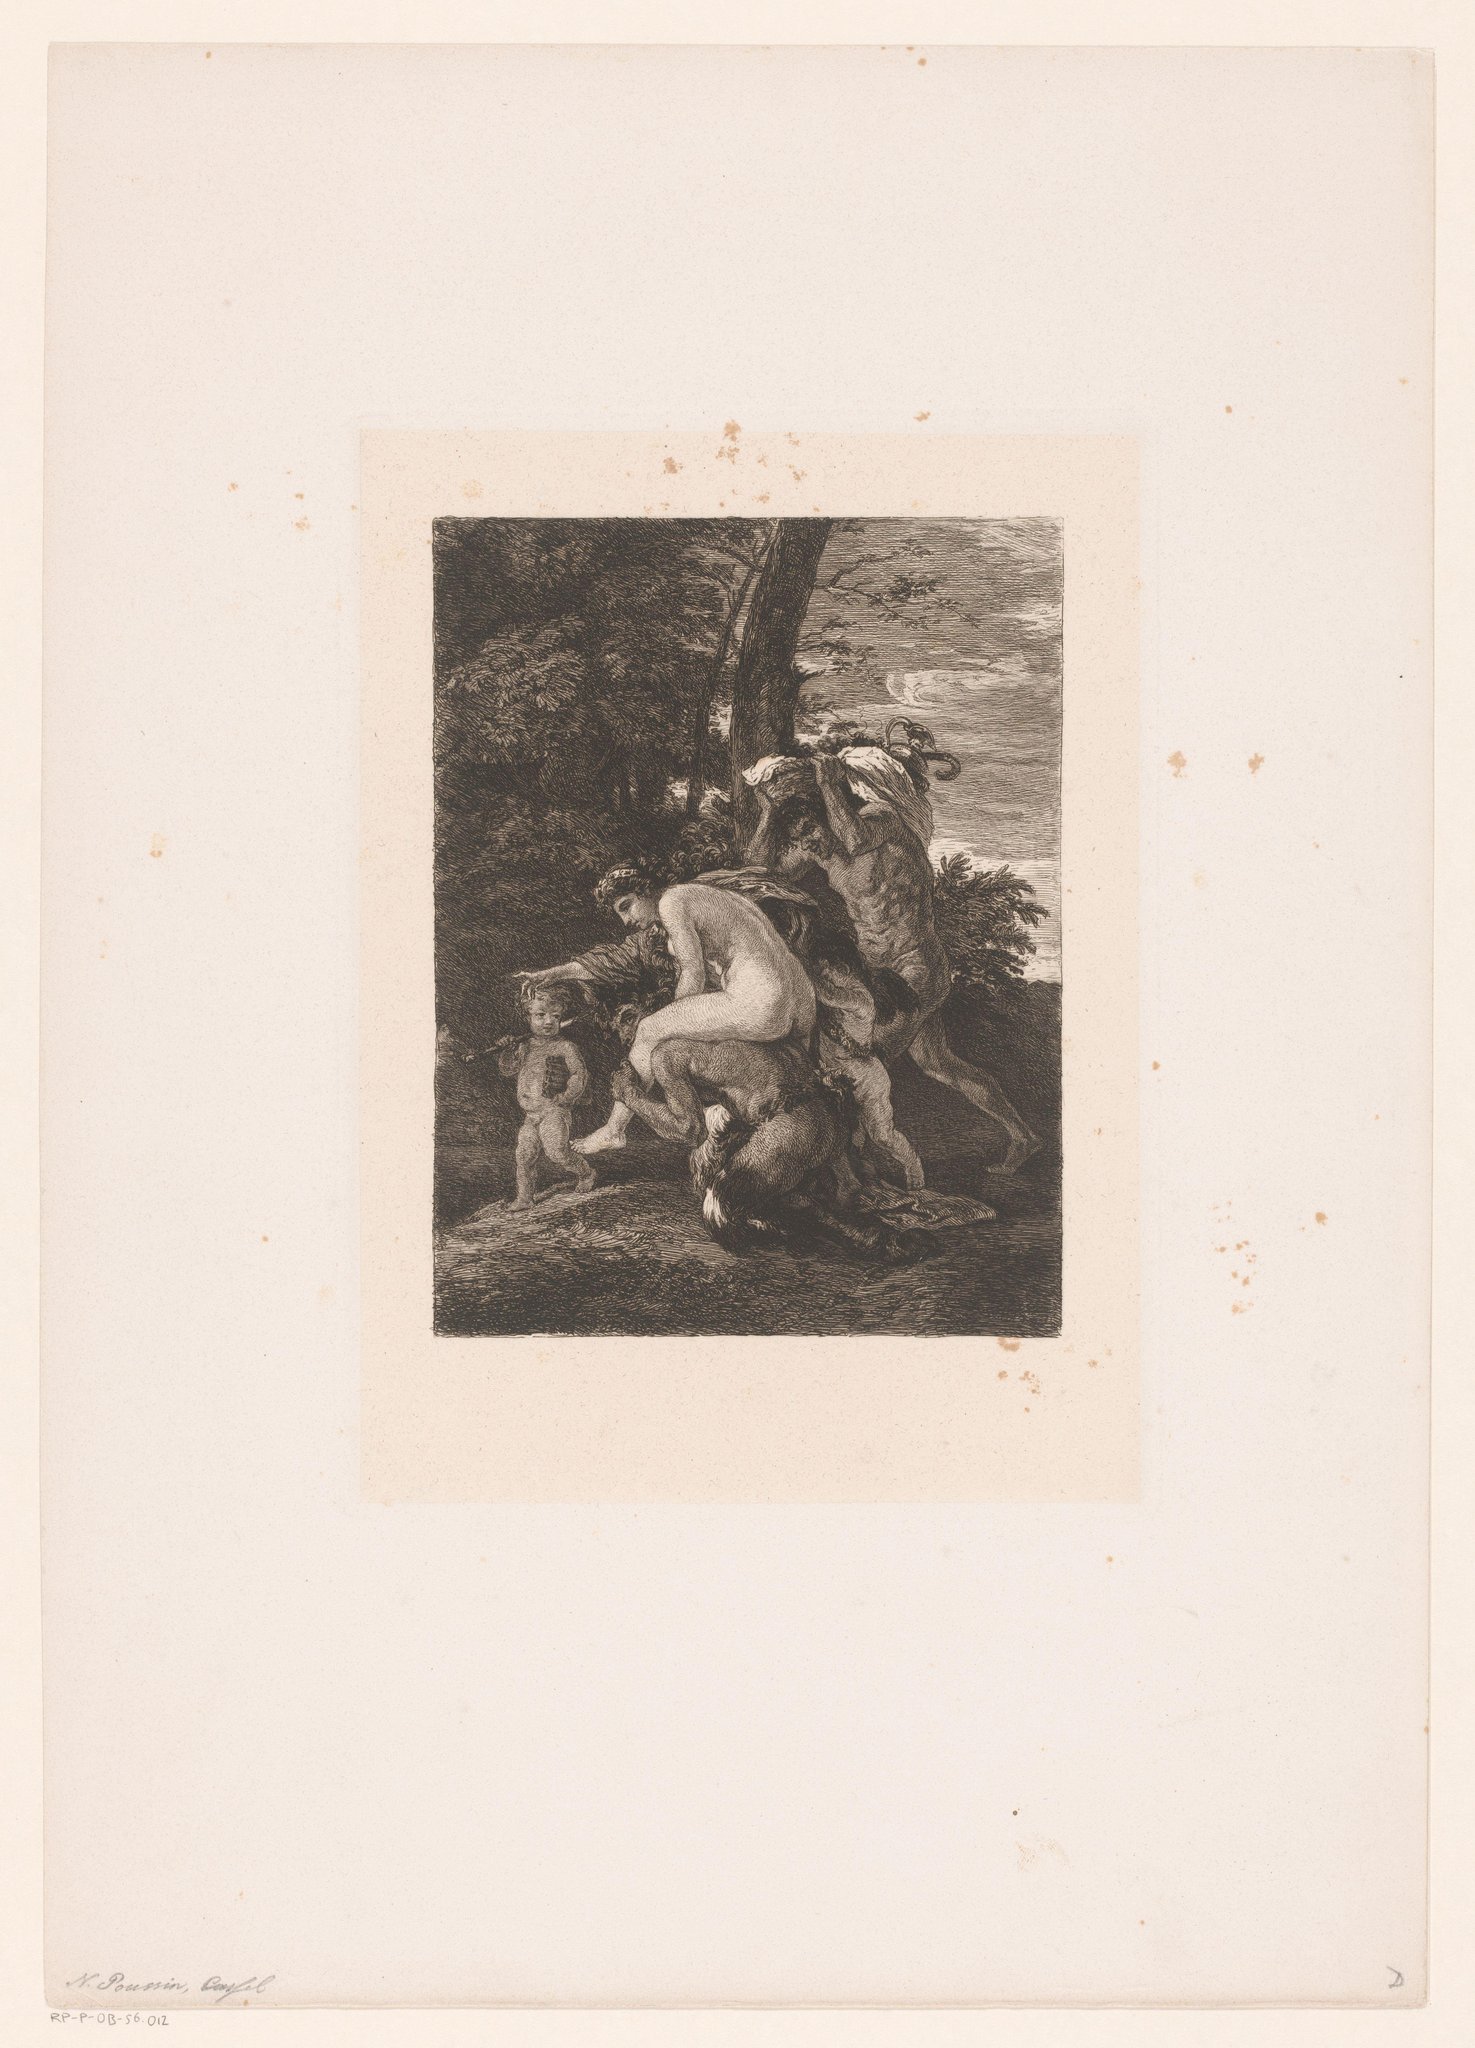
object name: print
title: Bacchanten in een bosrijk landschap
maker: william unger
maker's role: draughtsman, painter, print maker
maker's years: 1837-1932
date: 1847-1889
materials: paper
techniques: etching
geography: germany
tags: panpipes, maenad(s), female bacchant(es), male bacchant(es)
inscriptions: collector's mark: Lugt 2228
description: Prent naar het schilderij door Nicolas Poussin in de Gemäldegalerie Alte Meister te Kassel (inv.nr. GK 459).